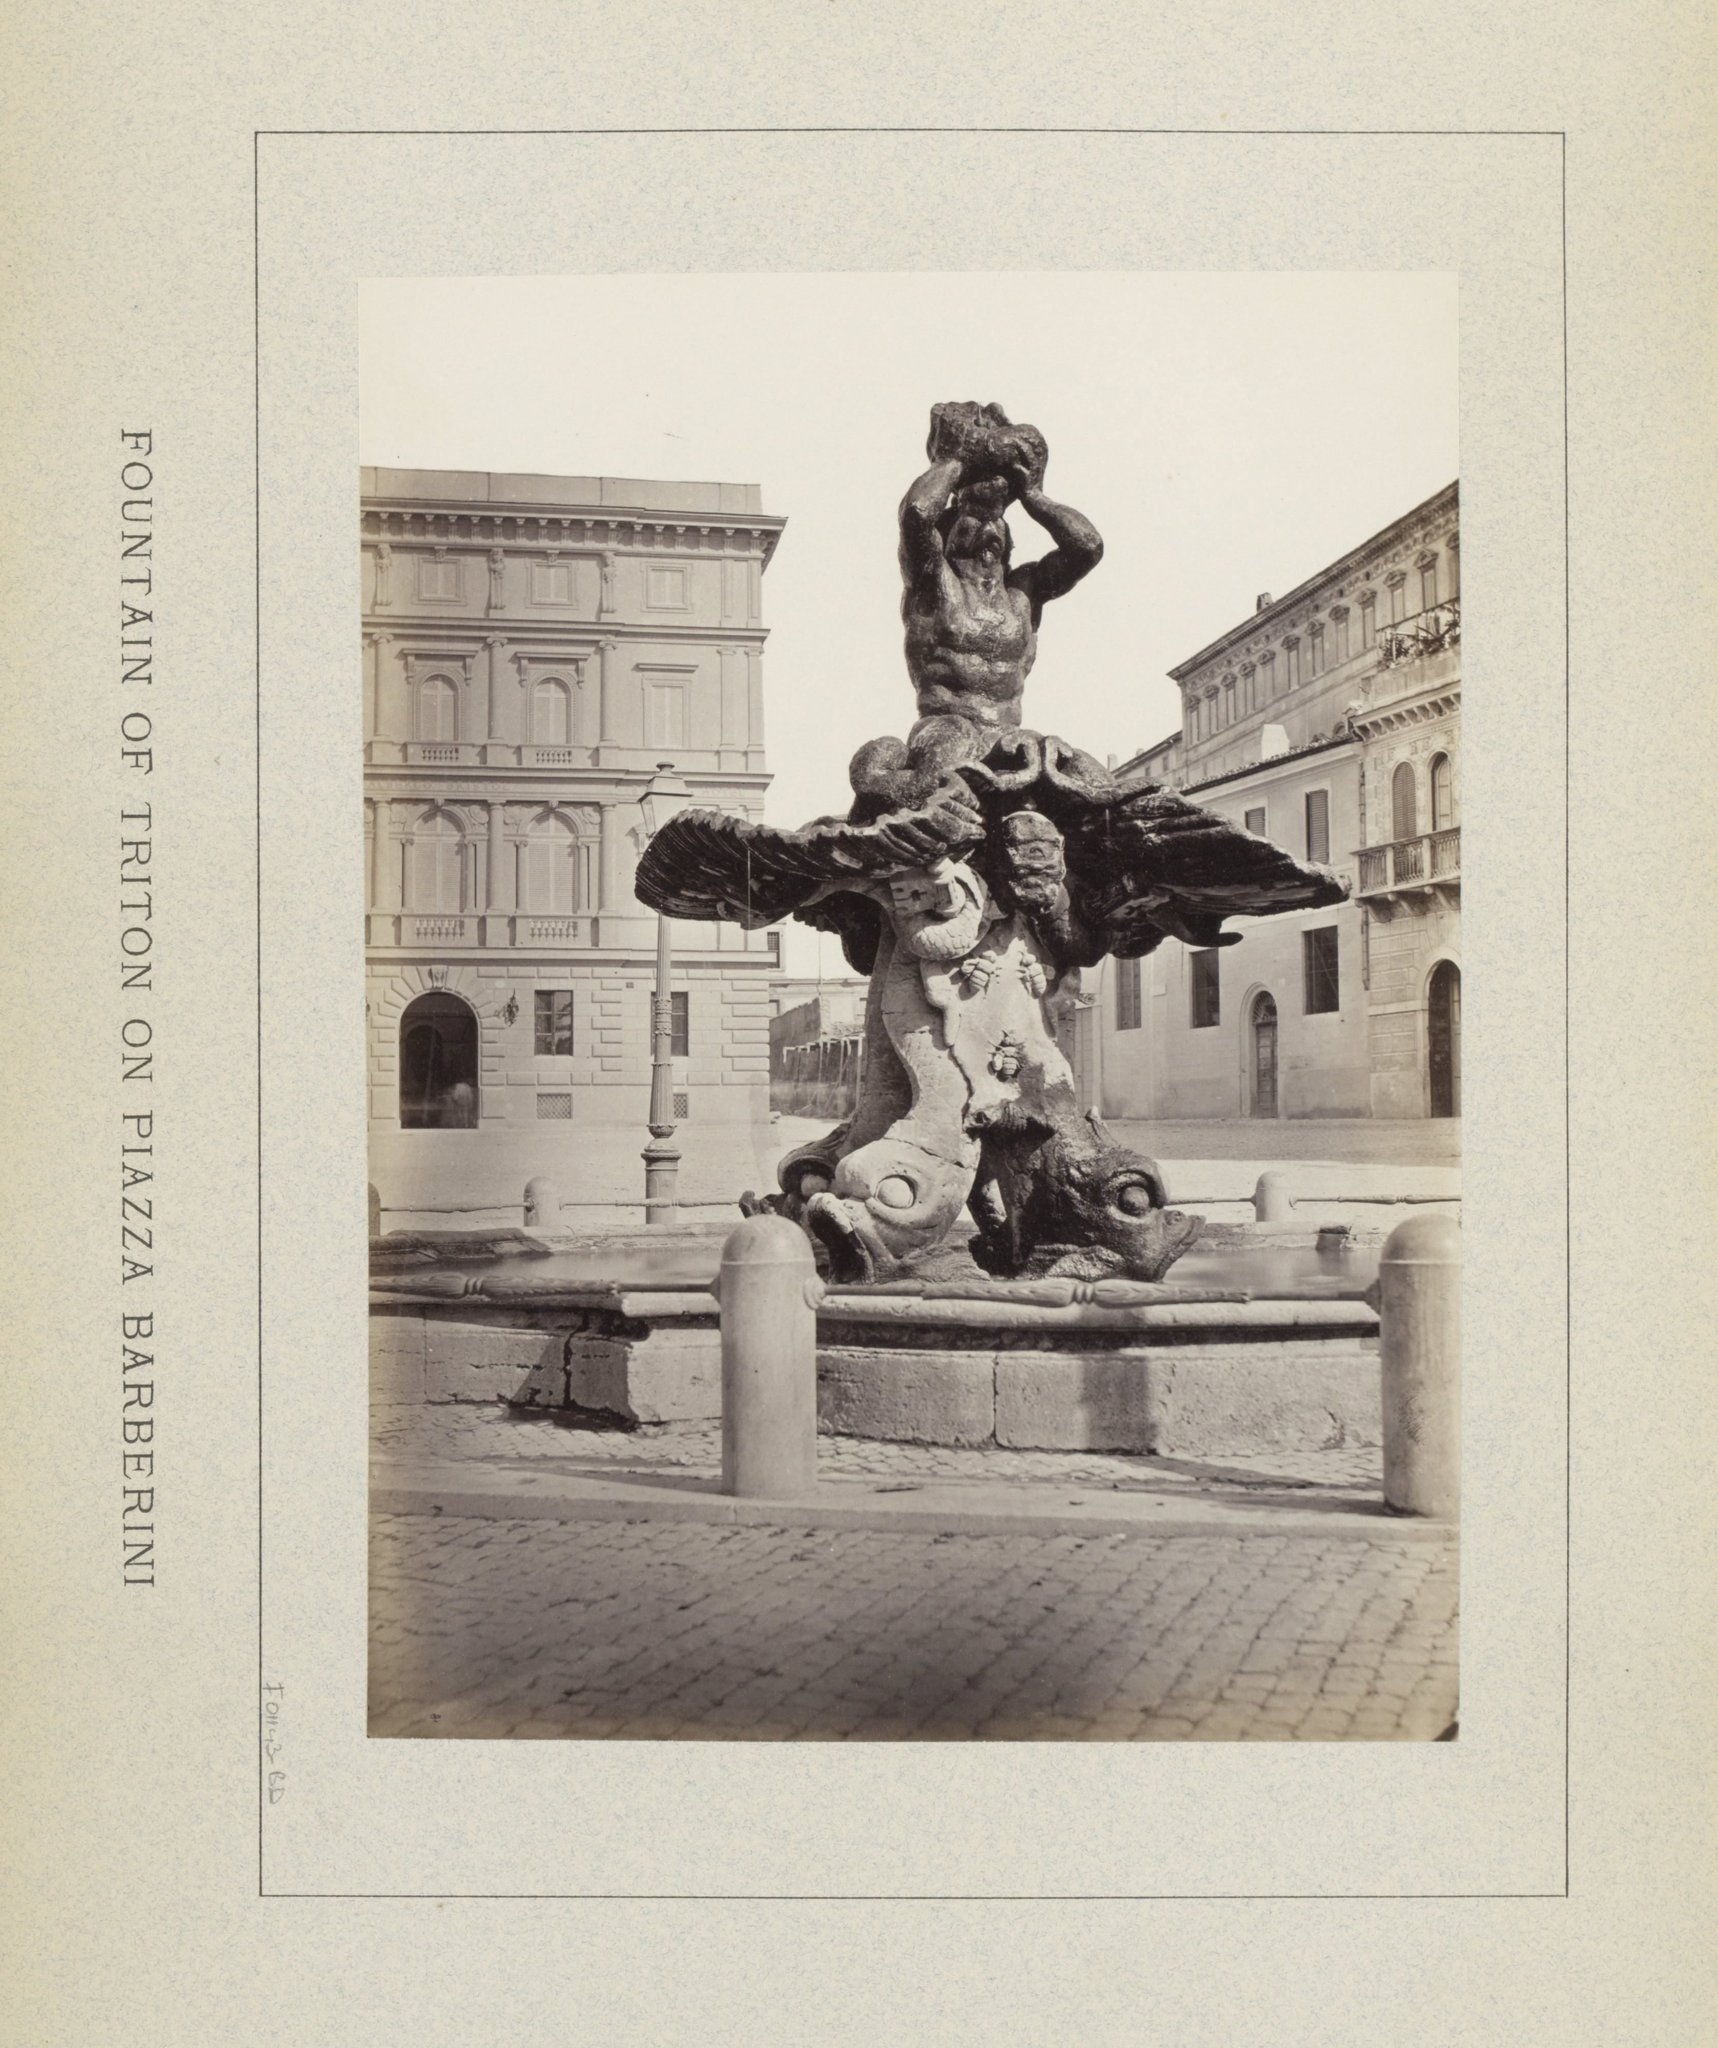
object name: photograph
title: Fountain of Triton on Piazza Barberini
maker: Anonymous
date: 1860-1900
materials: photographic support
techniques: albumen print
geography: rome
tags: piece of sculpture, reproduction of a piece of sculpture, ornamental fountain (+ city(-scape) with figures, staffage)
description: Onderdeel van Fotoalbum met opnames van bezienswaardigheden en kunstwerken in Rome.